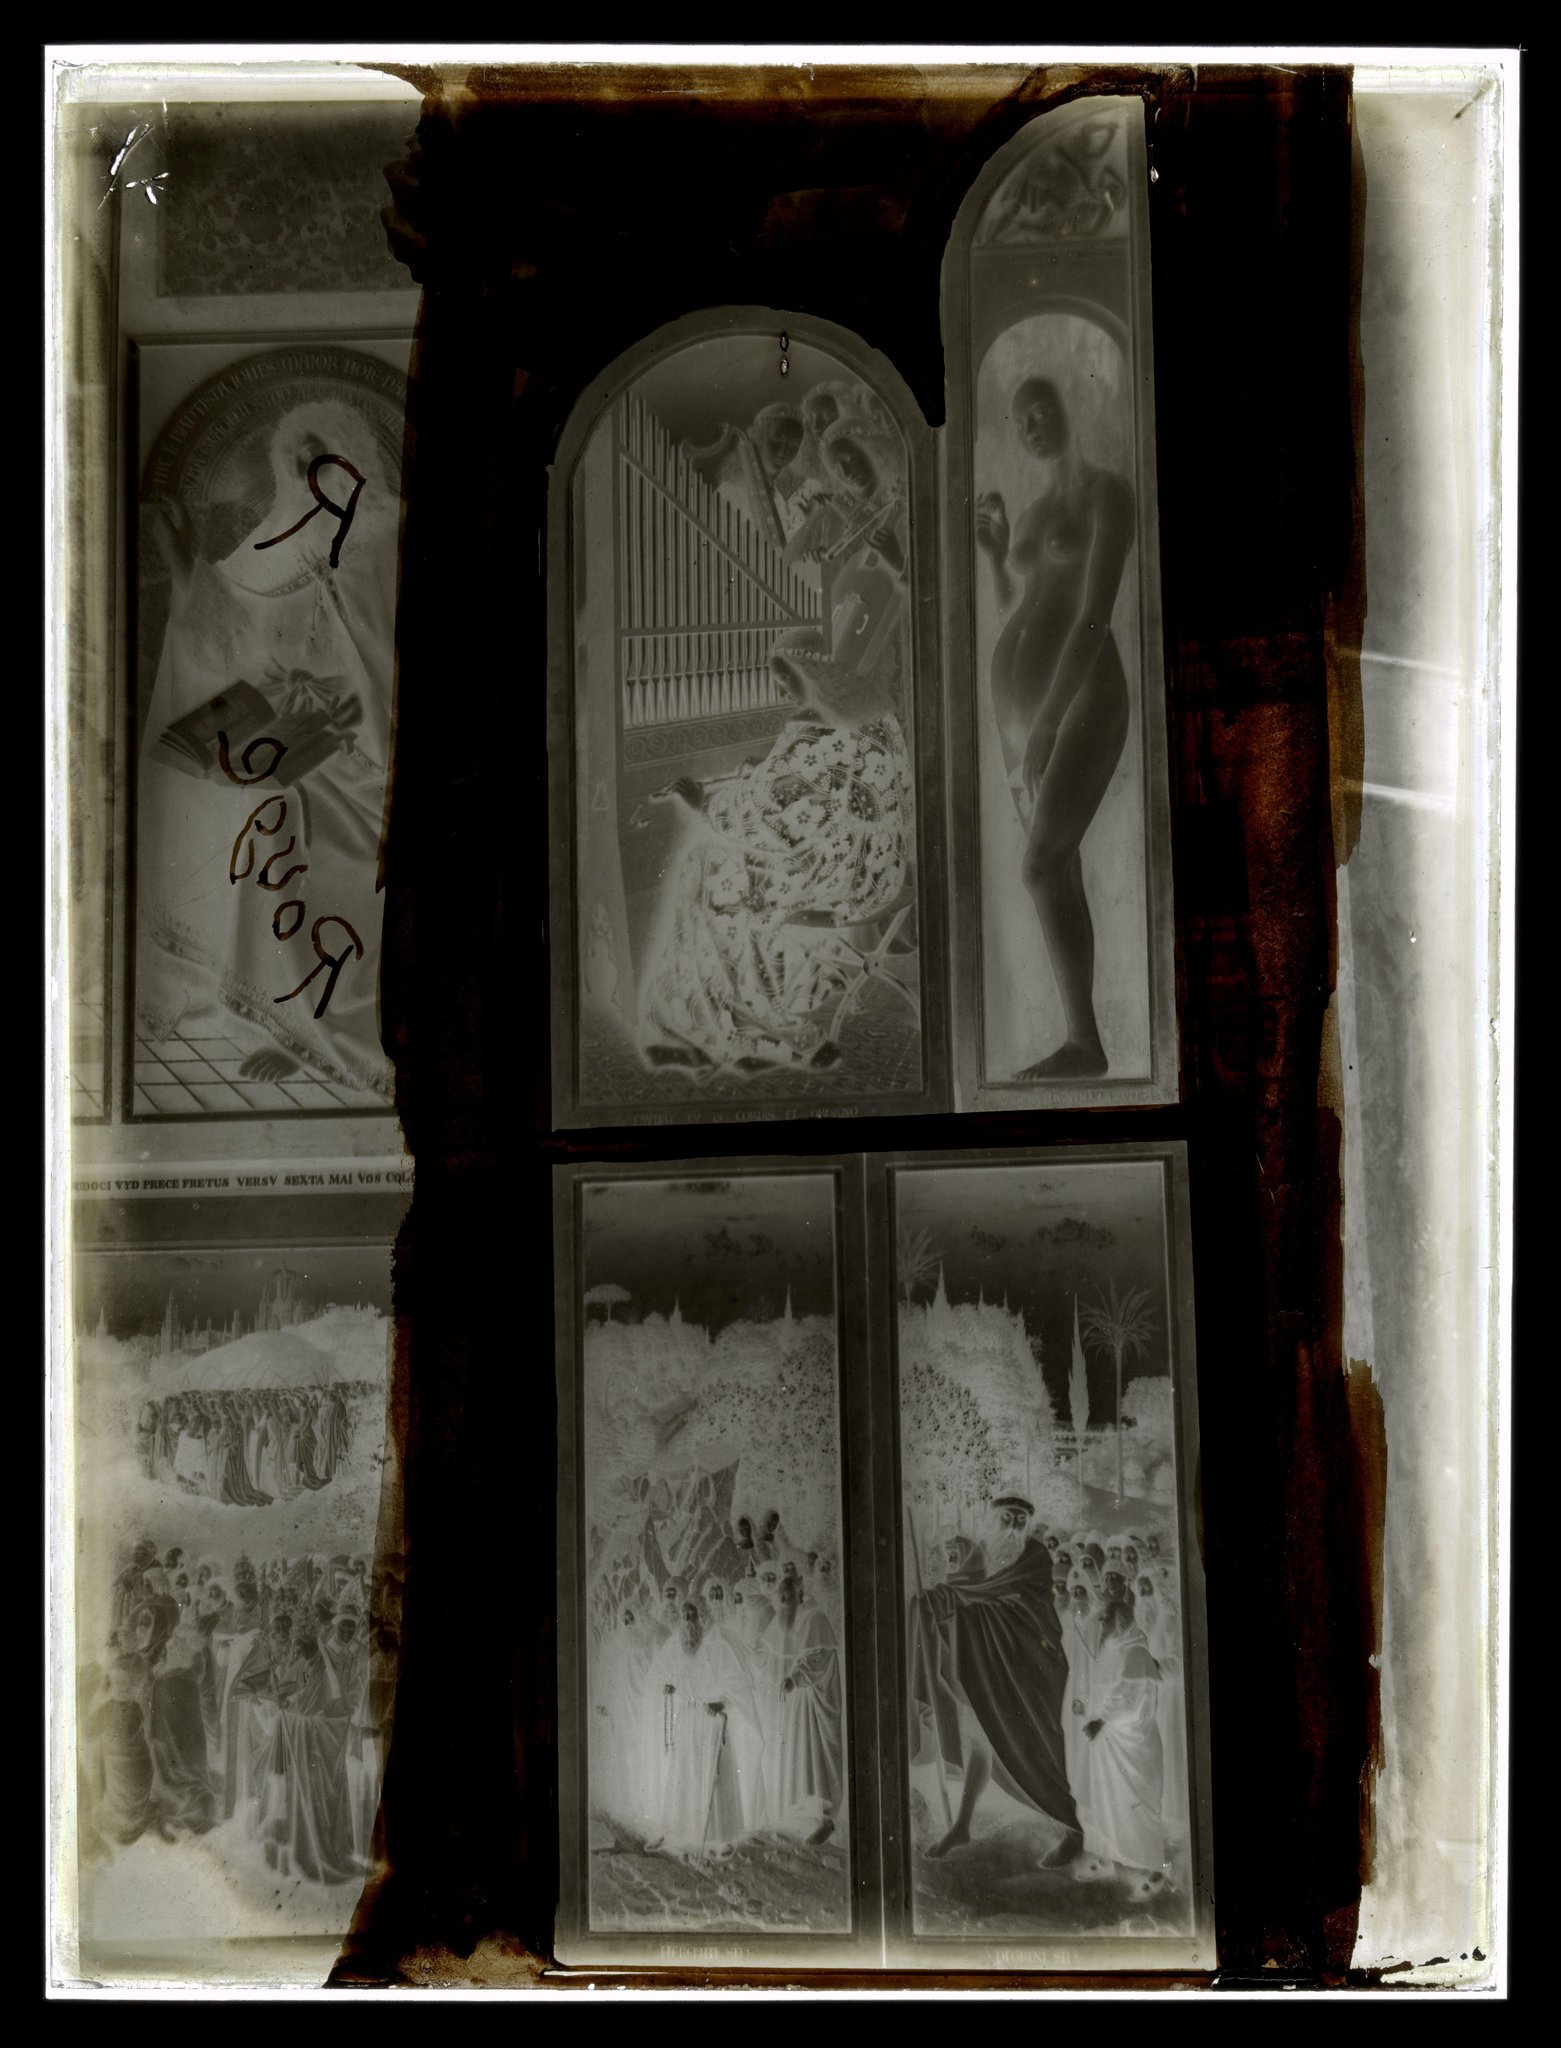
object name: photograph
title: Deelnegatief van het rechterpaneel van het altaarstuk De aanbidding van het Lam Gods door Hubert en Jan van Eyck, opgesteld in de Sint-Baafskathedraal, Gent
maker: Anonymous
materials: glass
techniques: gelatin glass negative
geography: ghent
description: Gefotografeerd door een rood-, groen- en blauwfilter.